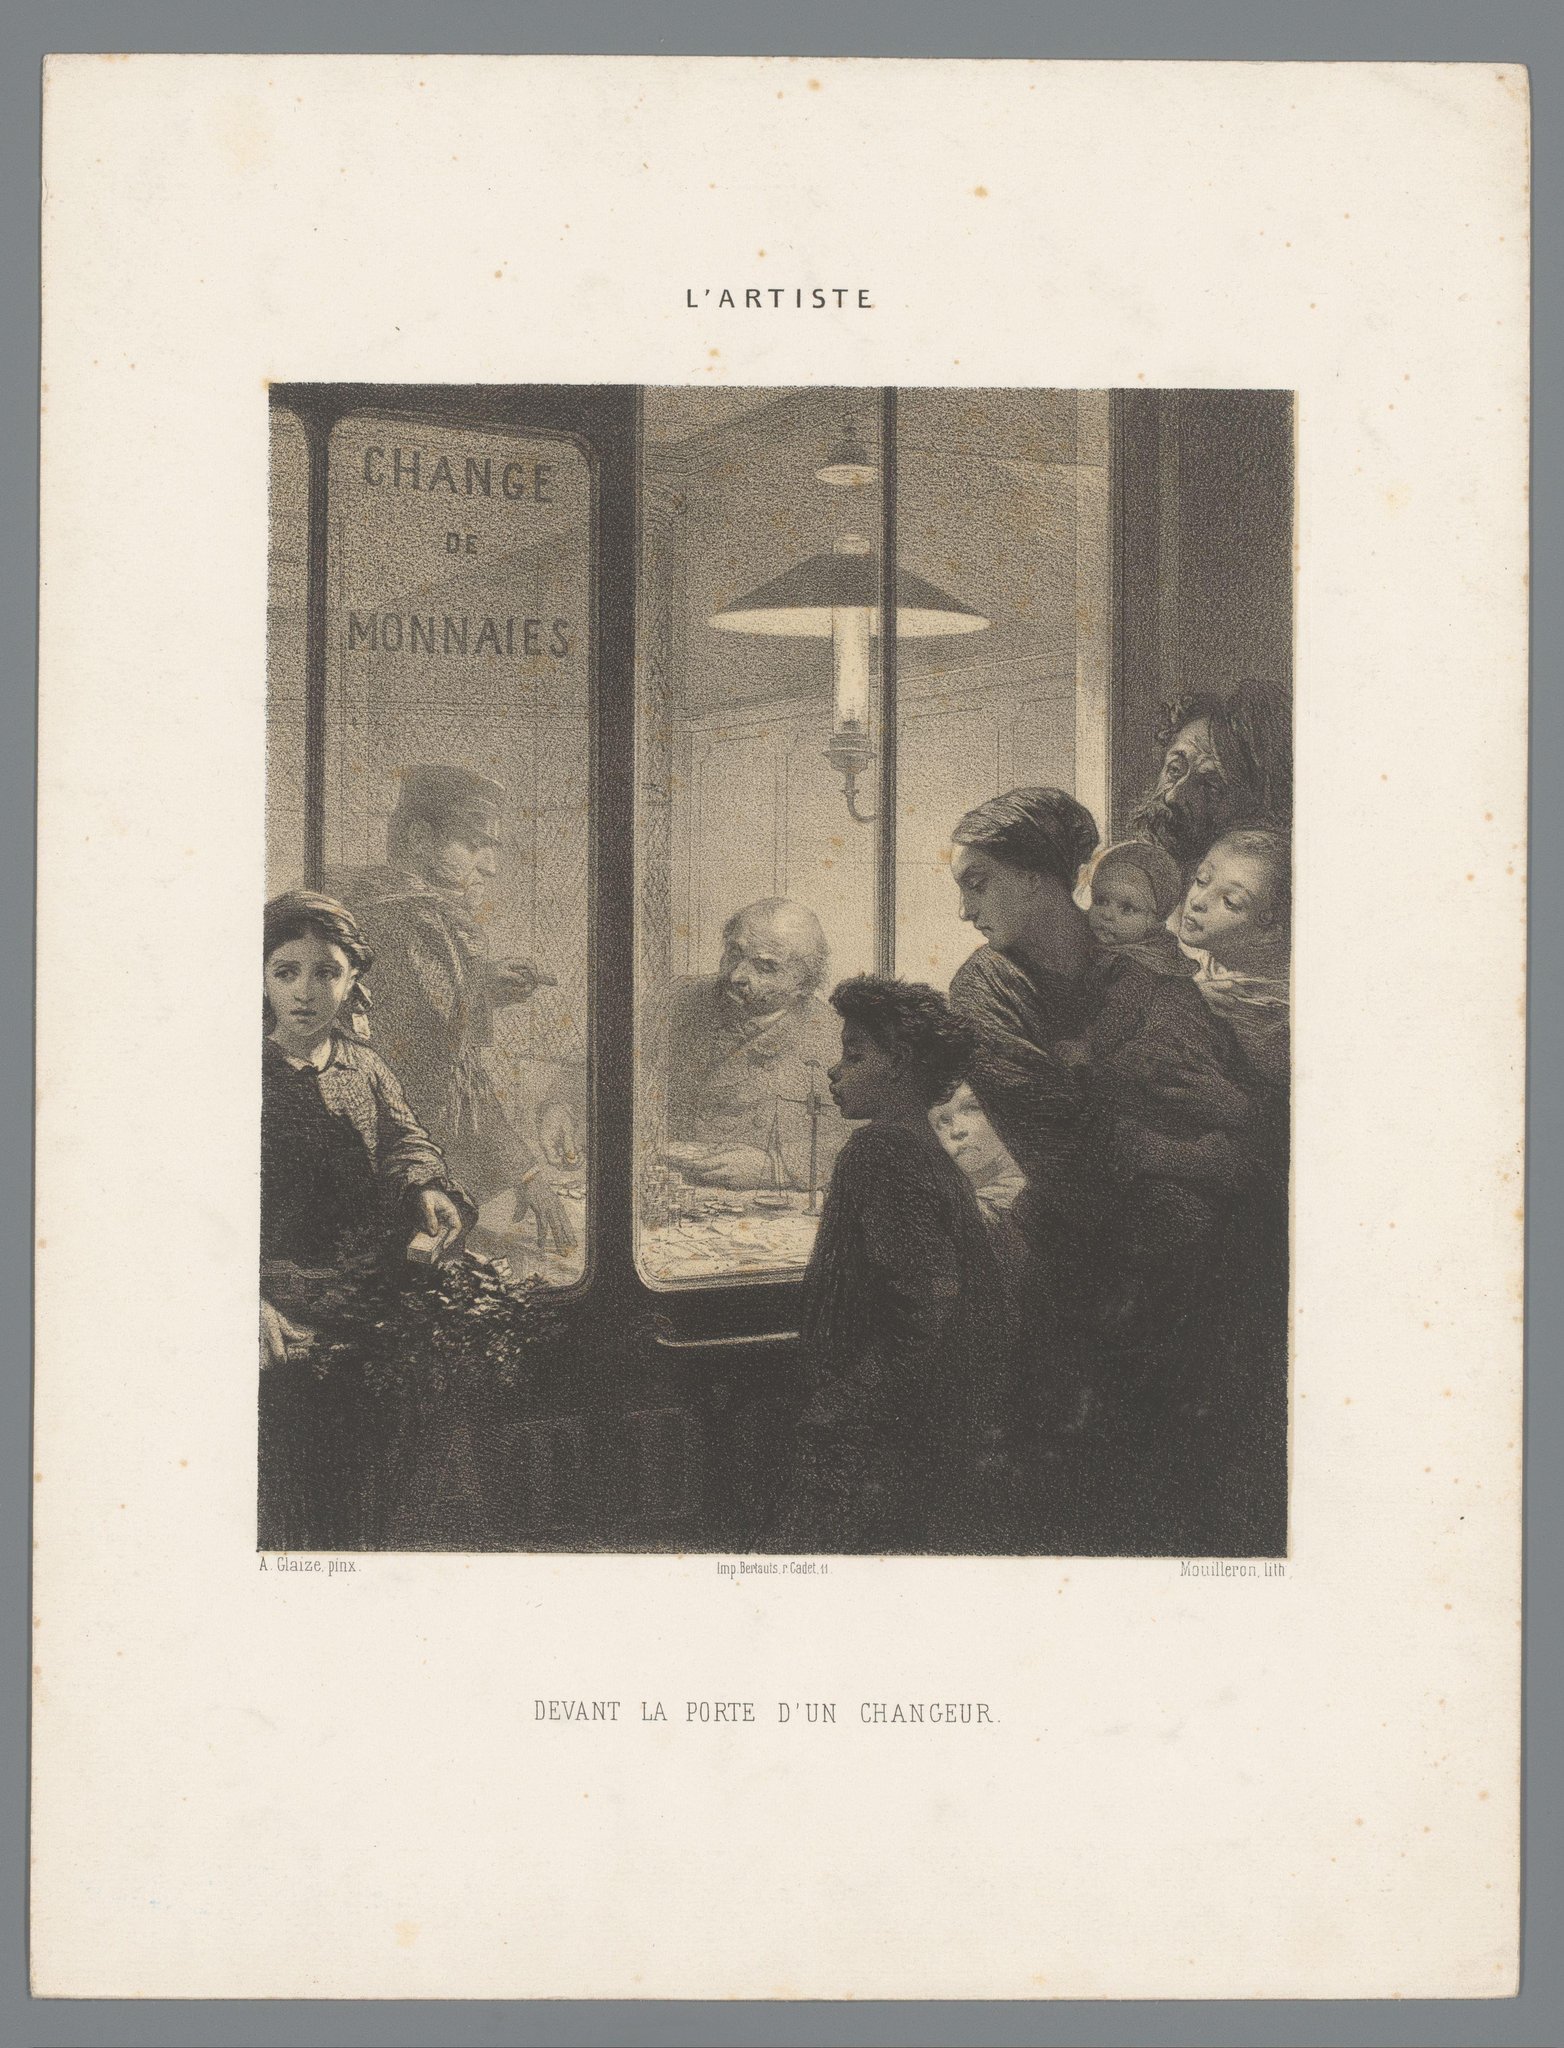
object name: print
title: Devant la porte d'un changeur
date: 1859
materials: paper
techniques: lithograph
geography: paris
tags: money-changer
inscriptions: inscription: ‘Aug Allebé’, collector's mark: Lugt 2233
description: Prent gebruikt in: L'Artiste, 1859, dl. 6.